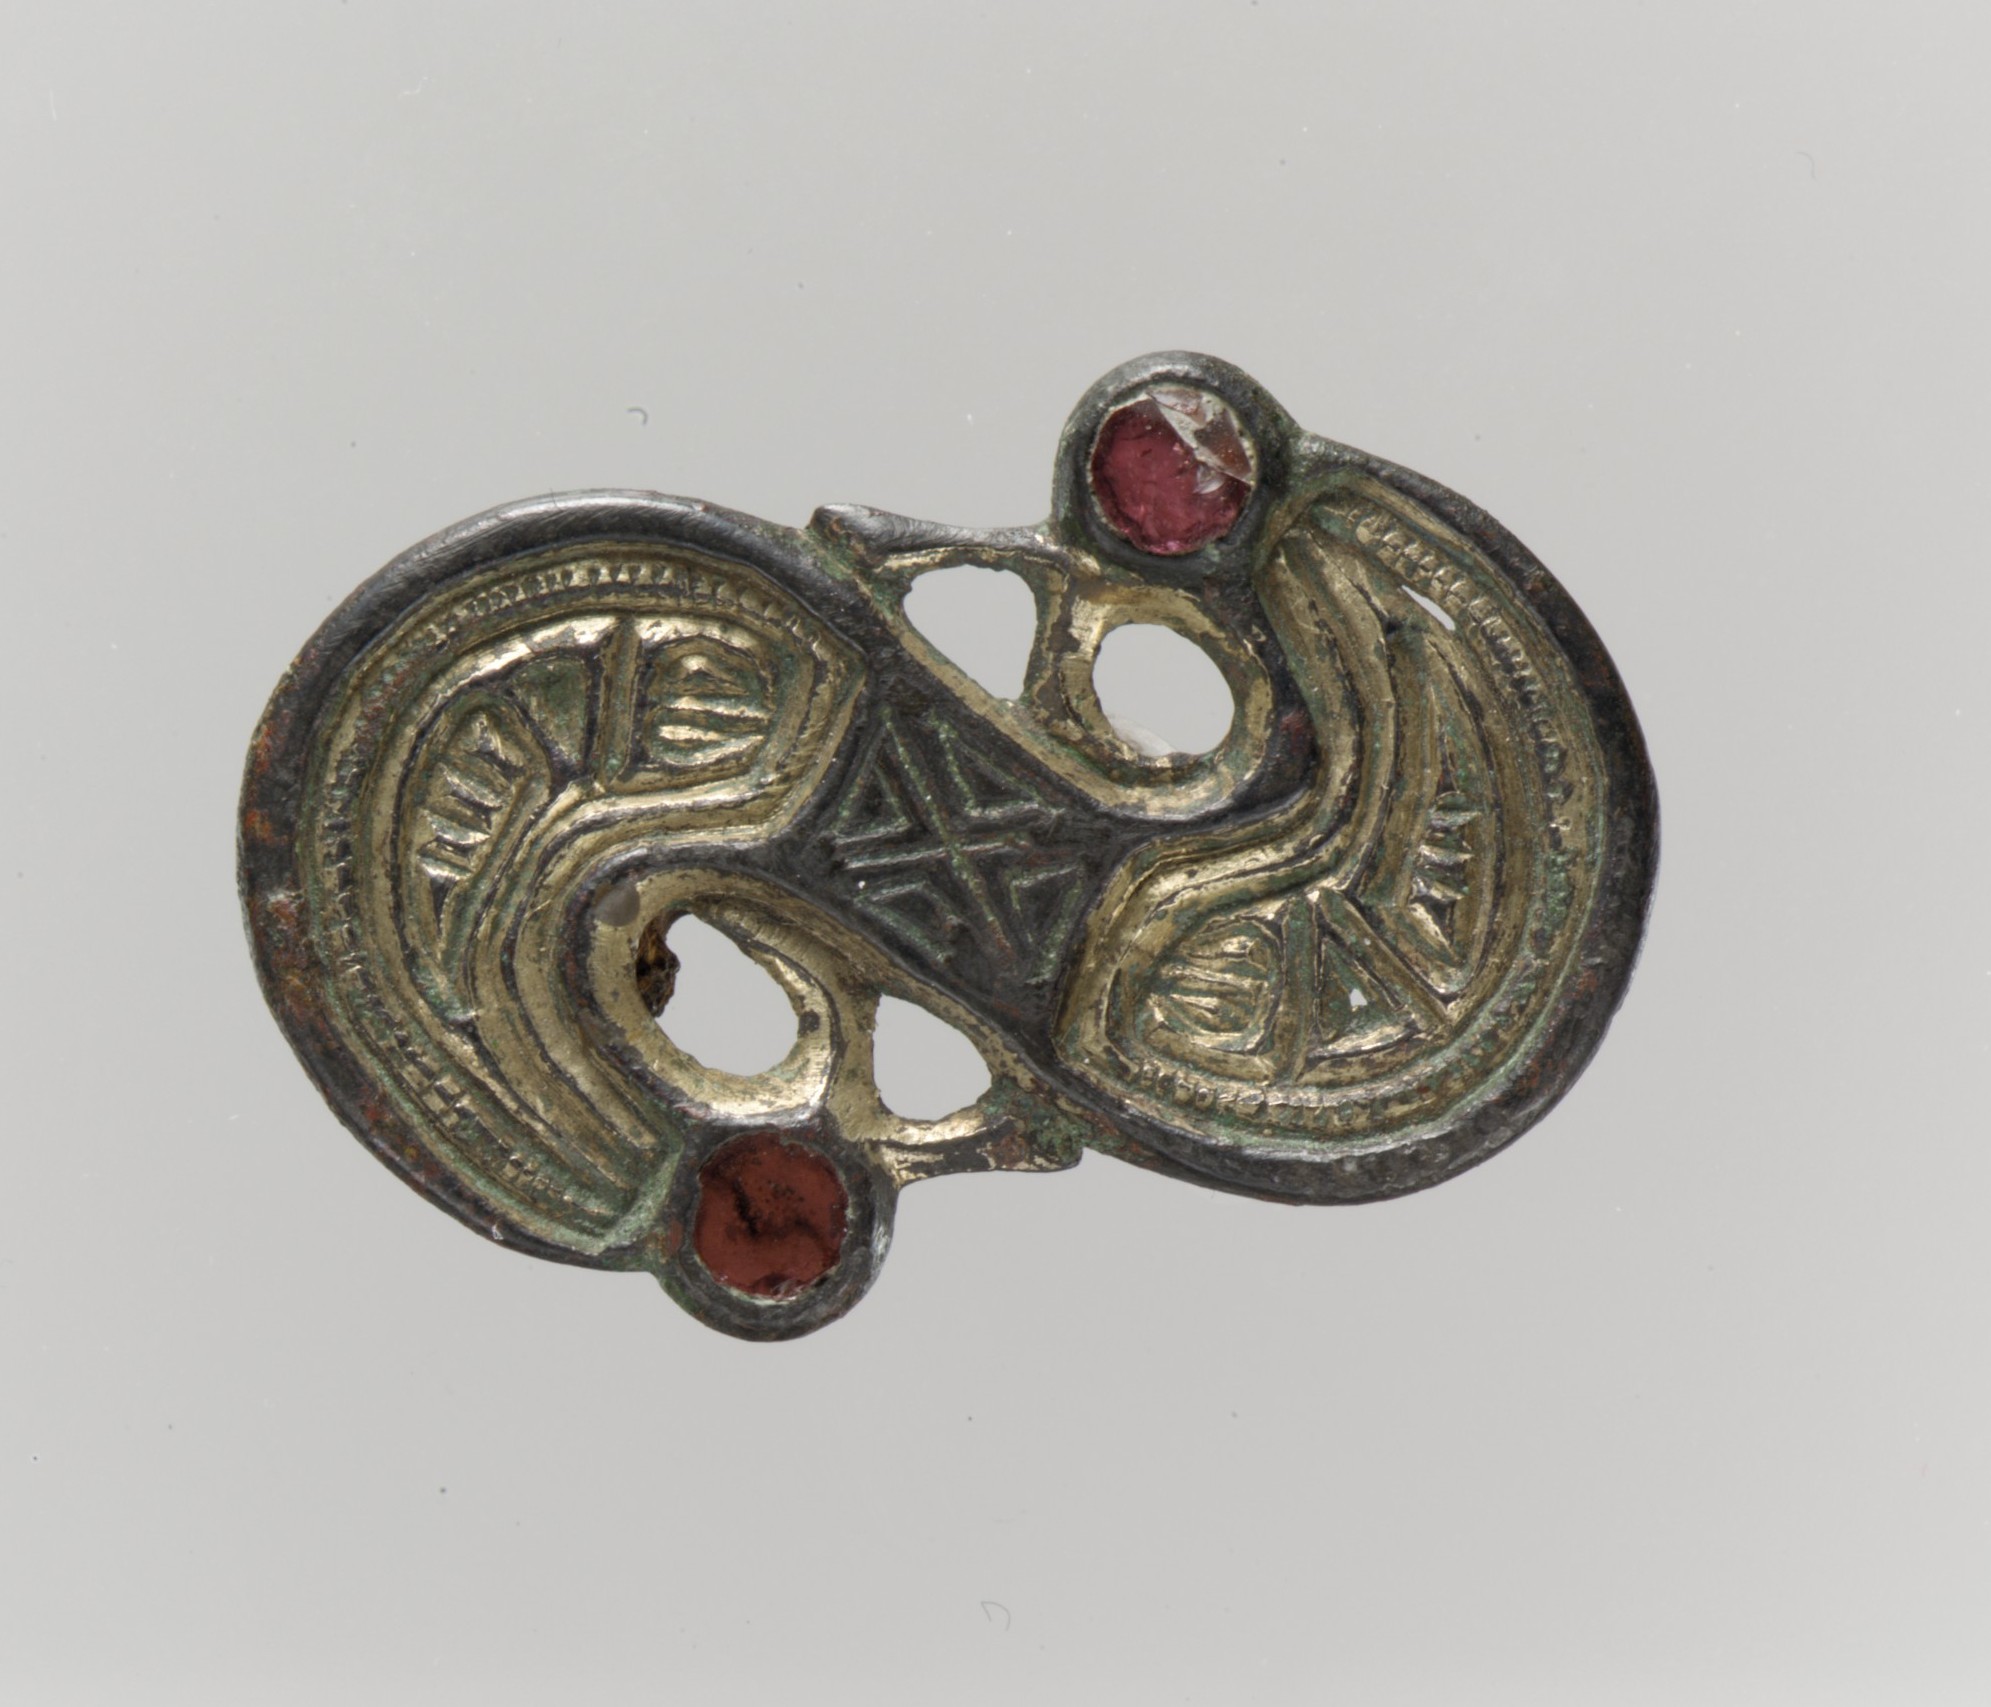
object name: brooch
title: S-Shaped Brooch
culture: frankish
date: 501-600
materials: garnet, gilt, niello, silver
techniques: casting, chasing, inlay, relief